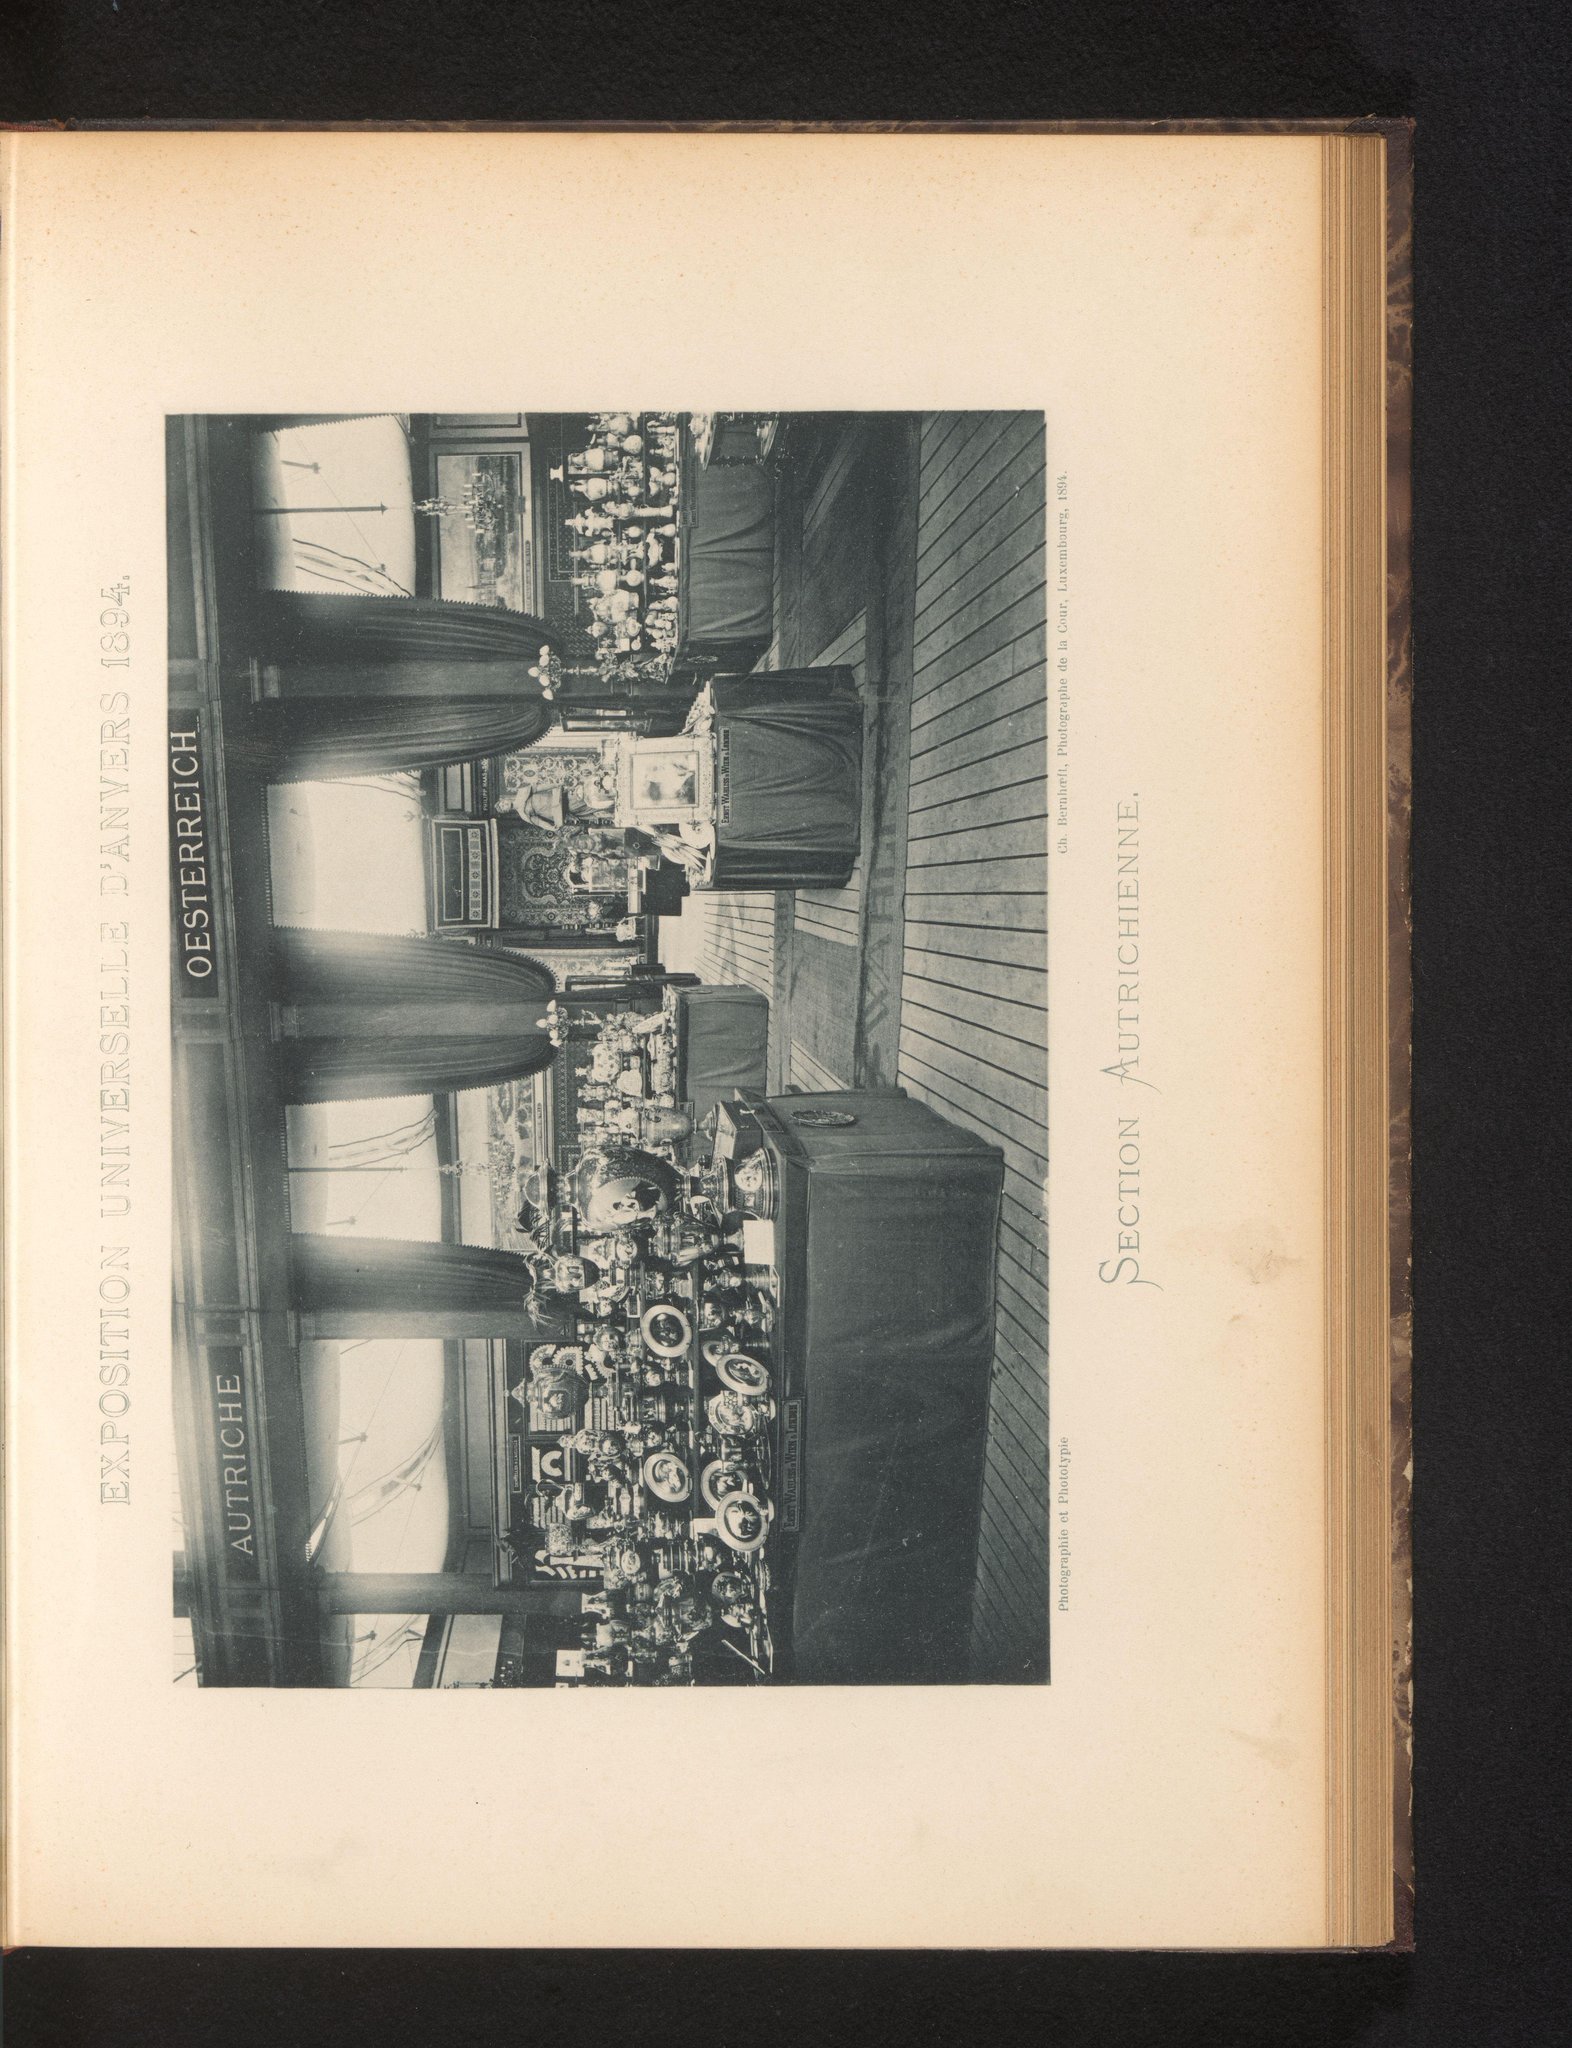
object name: photomechanical print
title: Gezicht op het Oostenrijkse deel van de Wereldtentoonstelling van Antwerpen in 1894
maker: charles bernhoeft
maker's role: publisher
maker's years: 1859-1933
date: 1894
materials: paper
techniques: photograph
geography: luxembourg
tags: counter ~ shop, world fair, world exhibition, container of ceramics: jar, jug, pot, vase, dish, plate, saucer, antwerp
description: Prent op derde ongenummerde pagina na pagina 42.